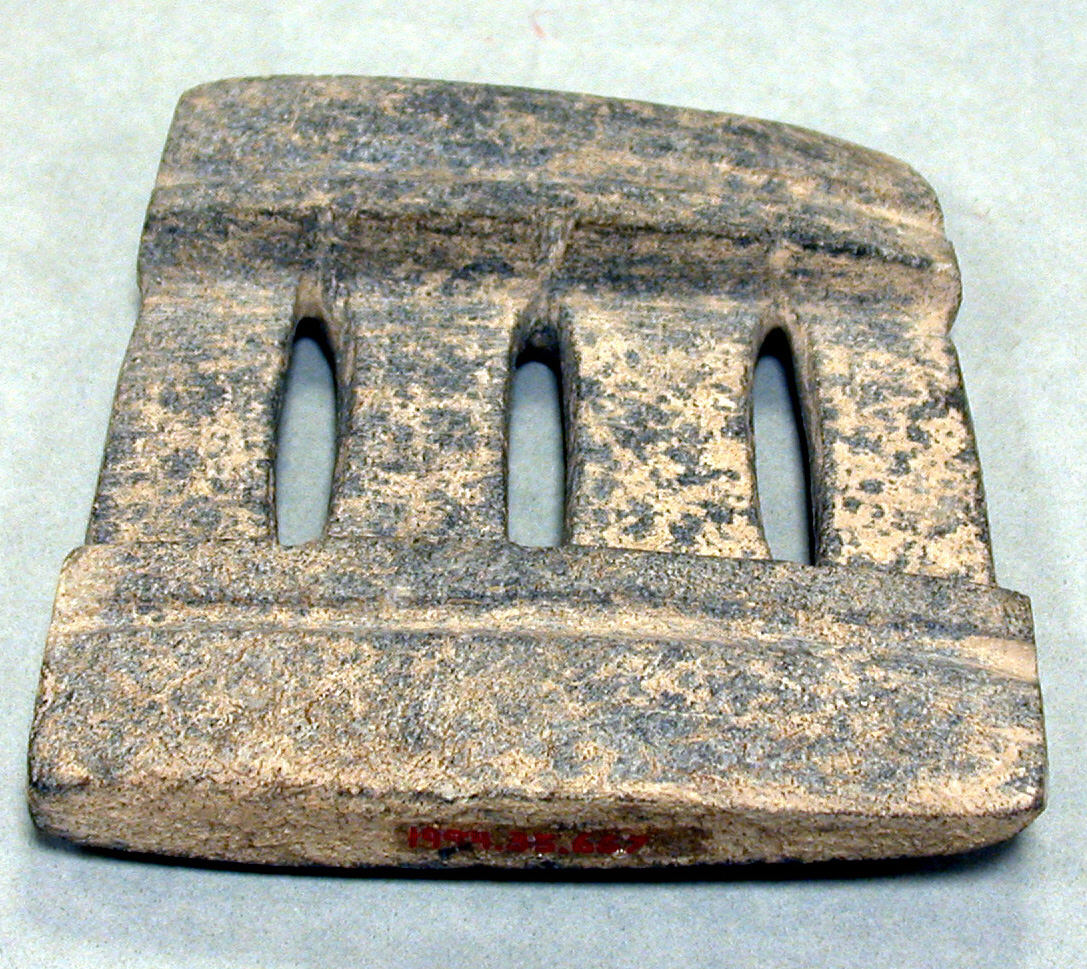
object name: architectural model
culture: mezcala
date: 1-800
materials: stone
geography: mexico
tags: temples